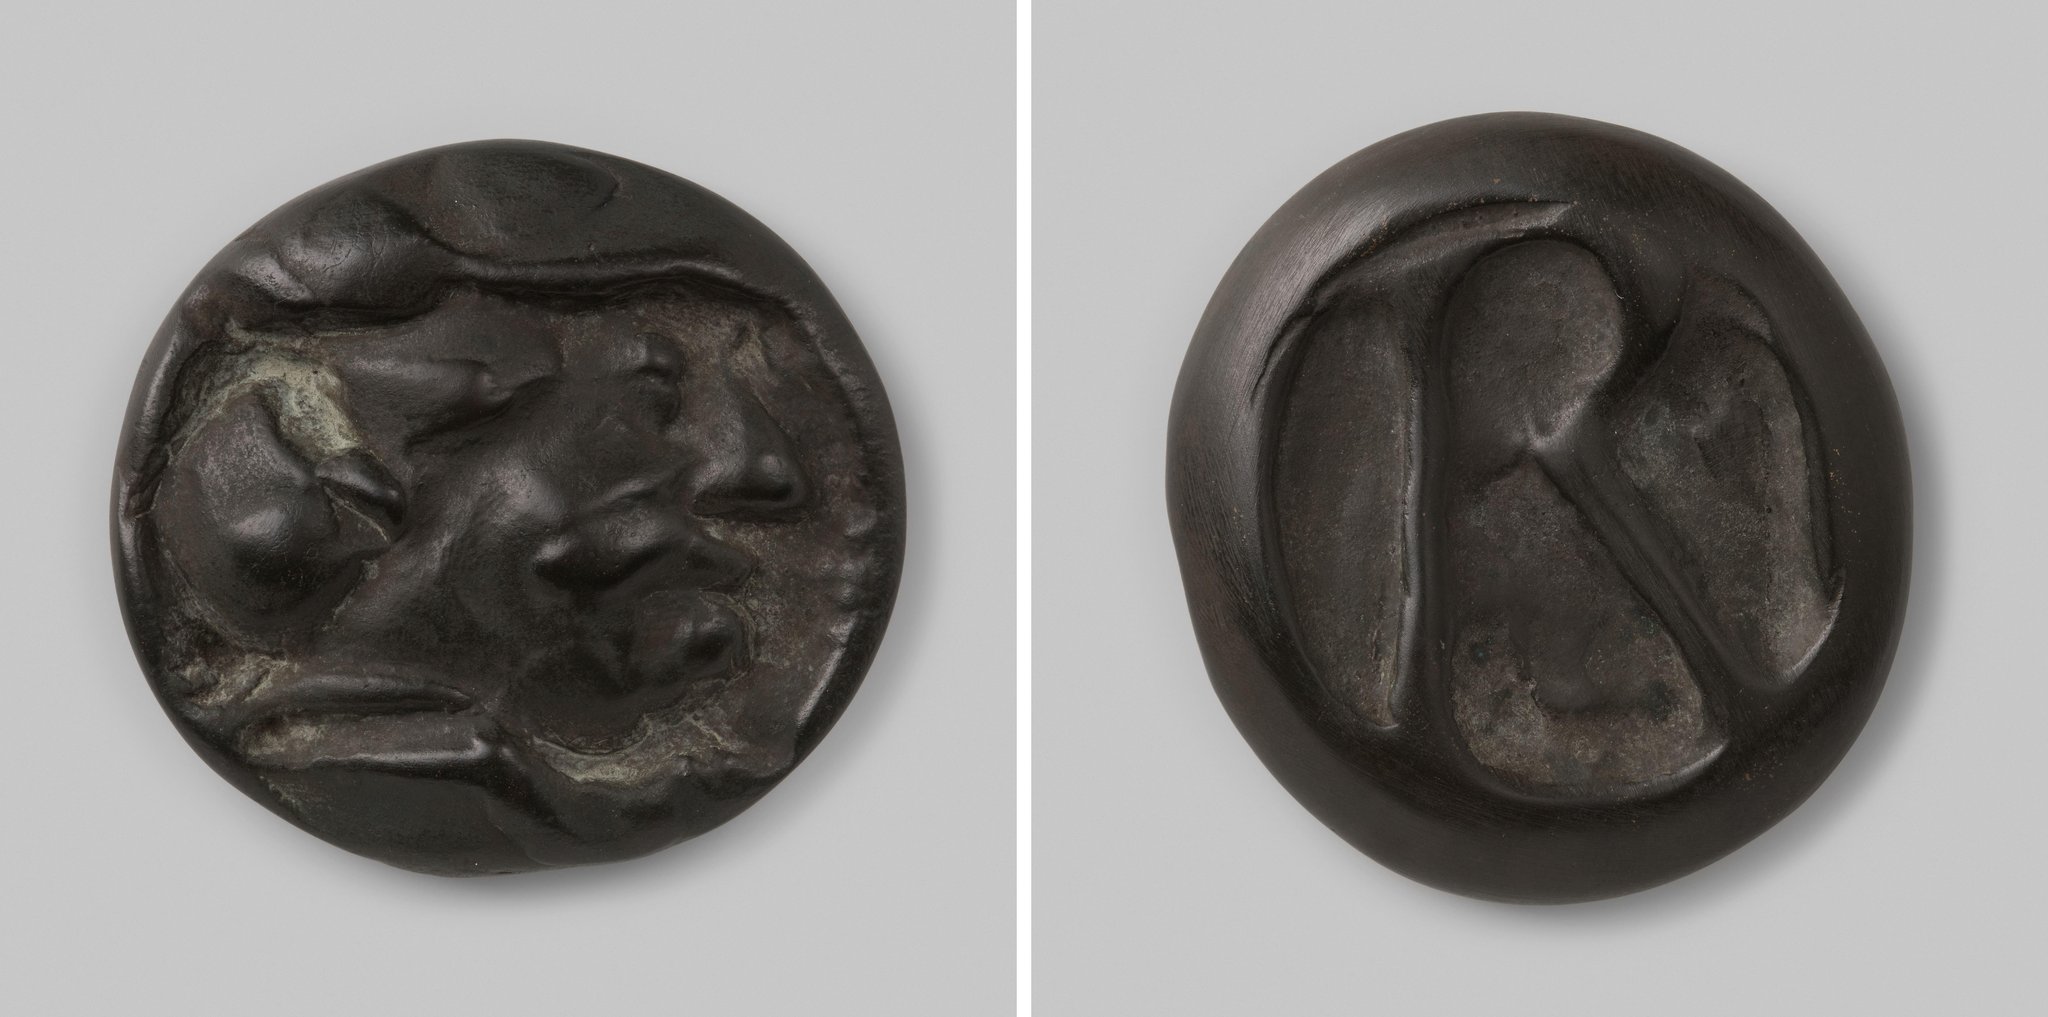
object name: history medal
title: De jonge Rembrandt (Vereniging voor Penningkunst 1988, tweede penning)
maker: vincent pieter semeyn esser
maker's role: hoogleraar, medailleur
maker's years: 1914-2004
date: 1988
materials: bronze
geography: netherlands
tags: amsterdam, draughtsman, rembrandt van rijn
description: Bronzen penning. Voorzijde: het hoofd van Rembrandt. Keerzijde: de letter R. Bisquit hiervan ook aanwezig.